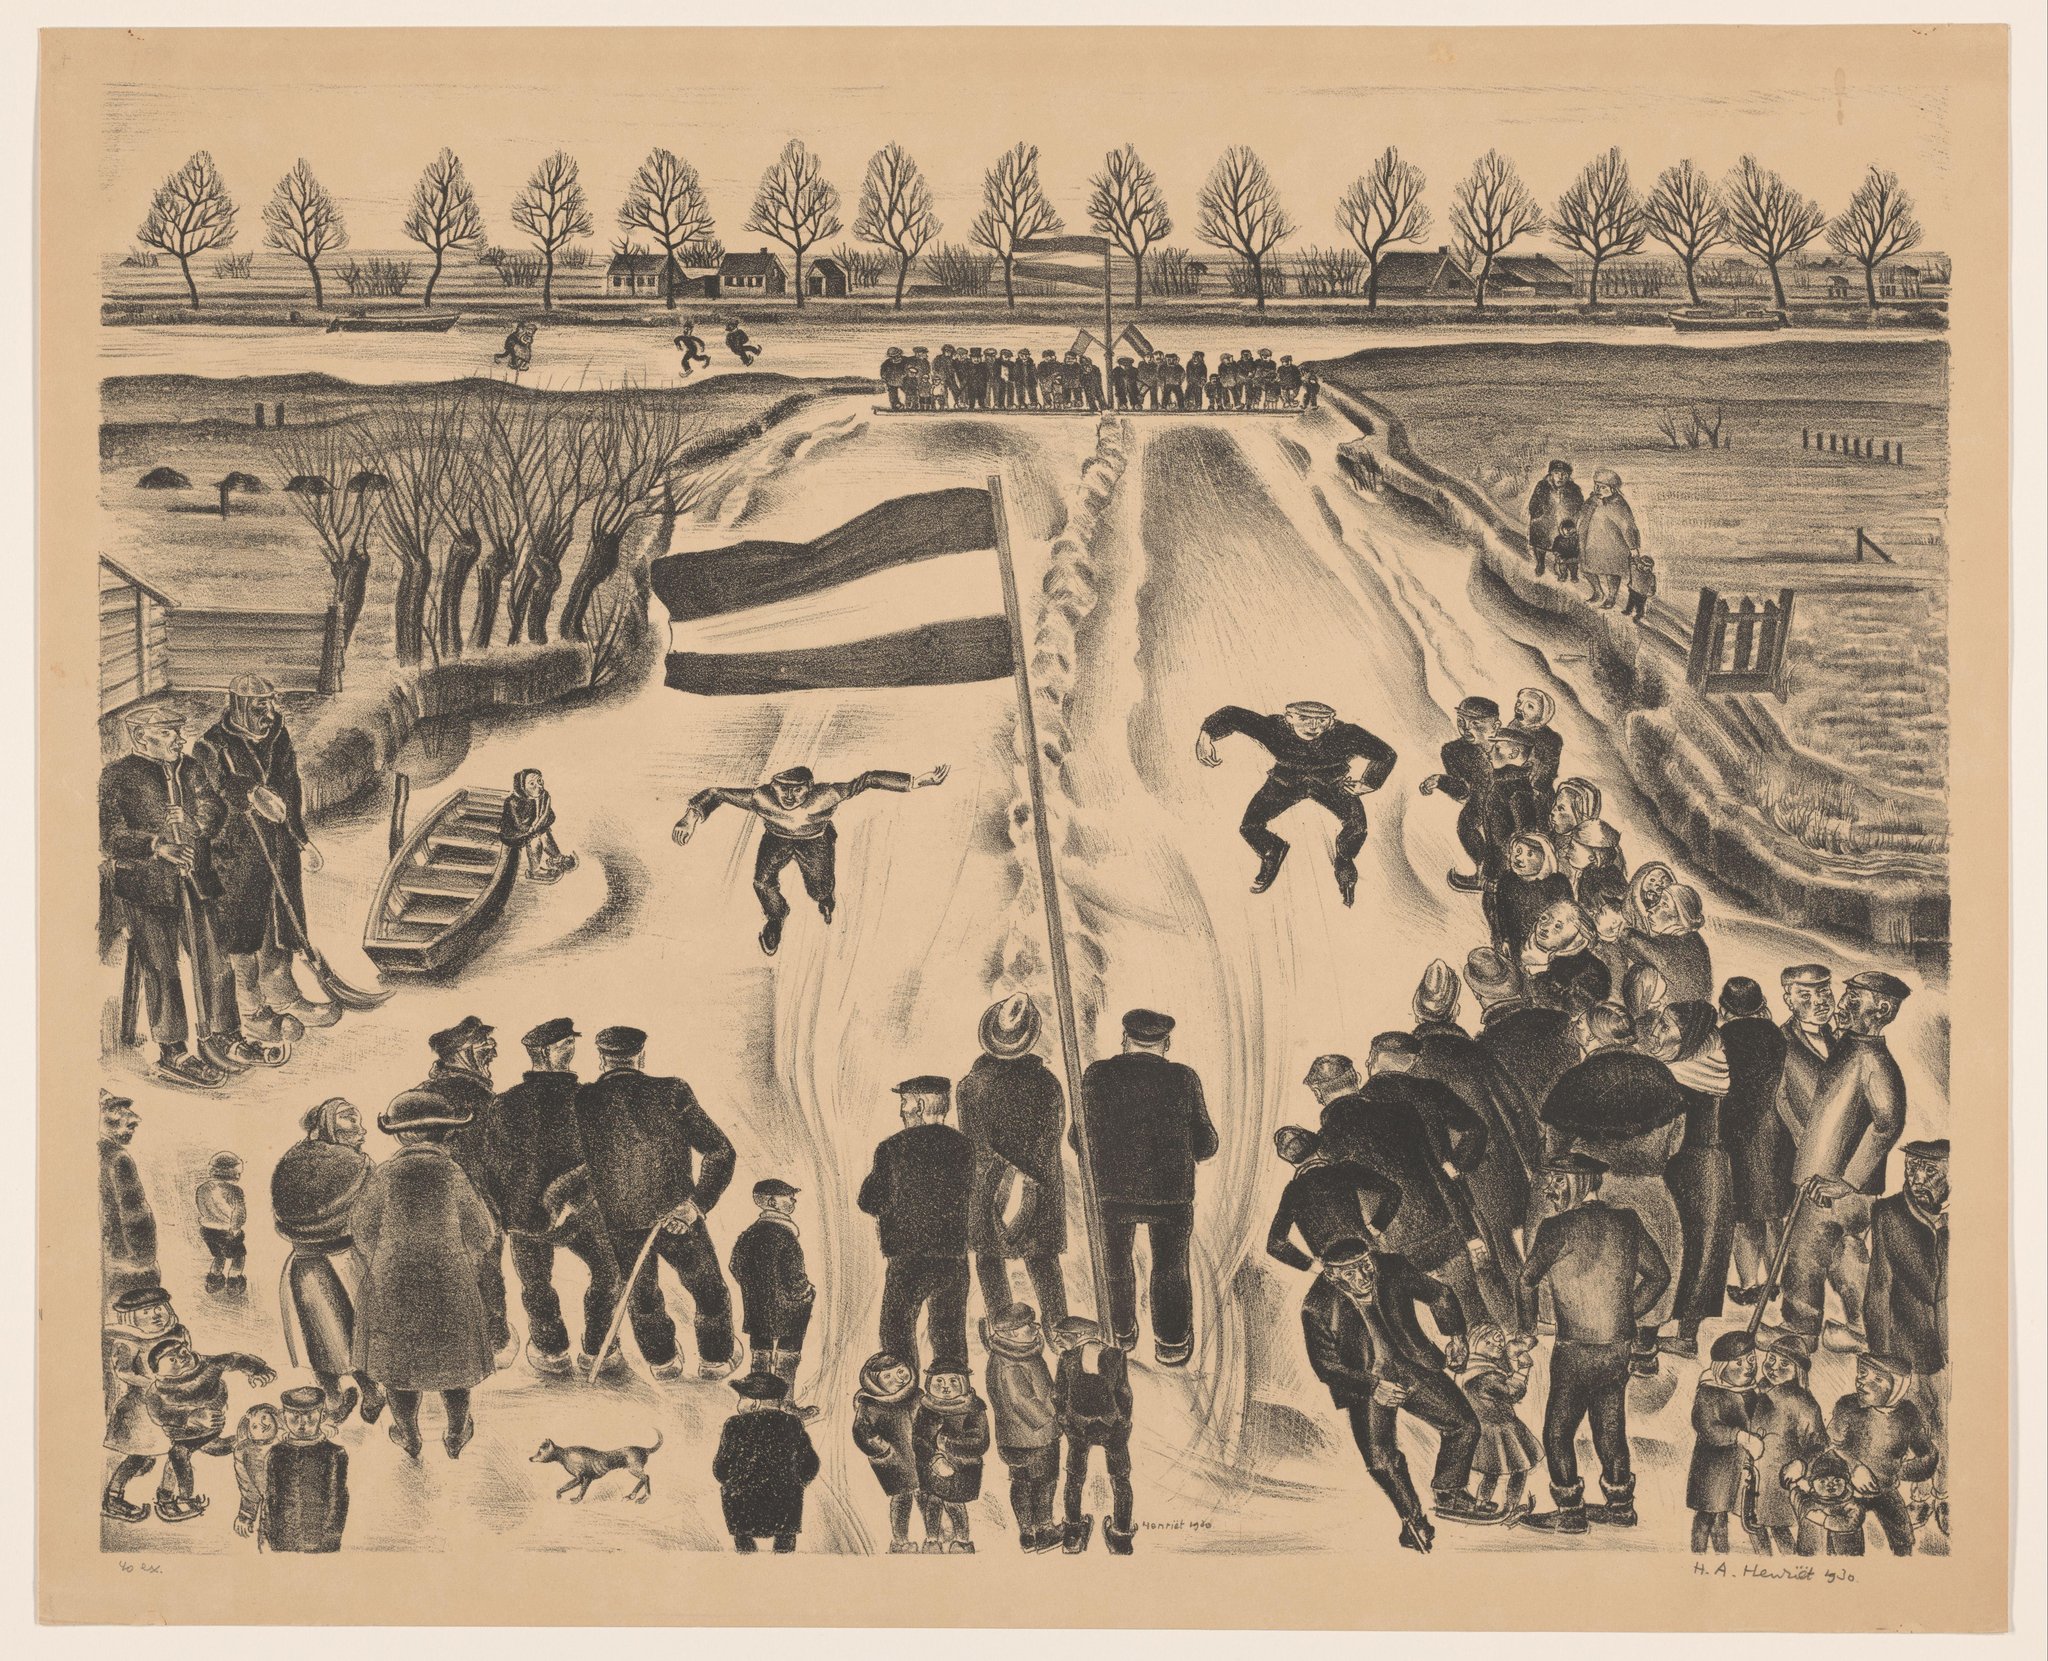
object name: print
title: Schaatswedstrijd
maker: henk henriët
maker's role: draughtsman, print maker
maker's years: 1903-1945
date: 1930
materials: paper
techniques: lithograph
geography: netherlands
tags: skates (winter sports) (+ the contest (sports, games, etc.)), winter landscape; landscape symbolizing winter (the four seasons of the year)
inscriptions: collector's mark: Lugt 2228